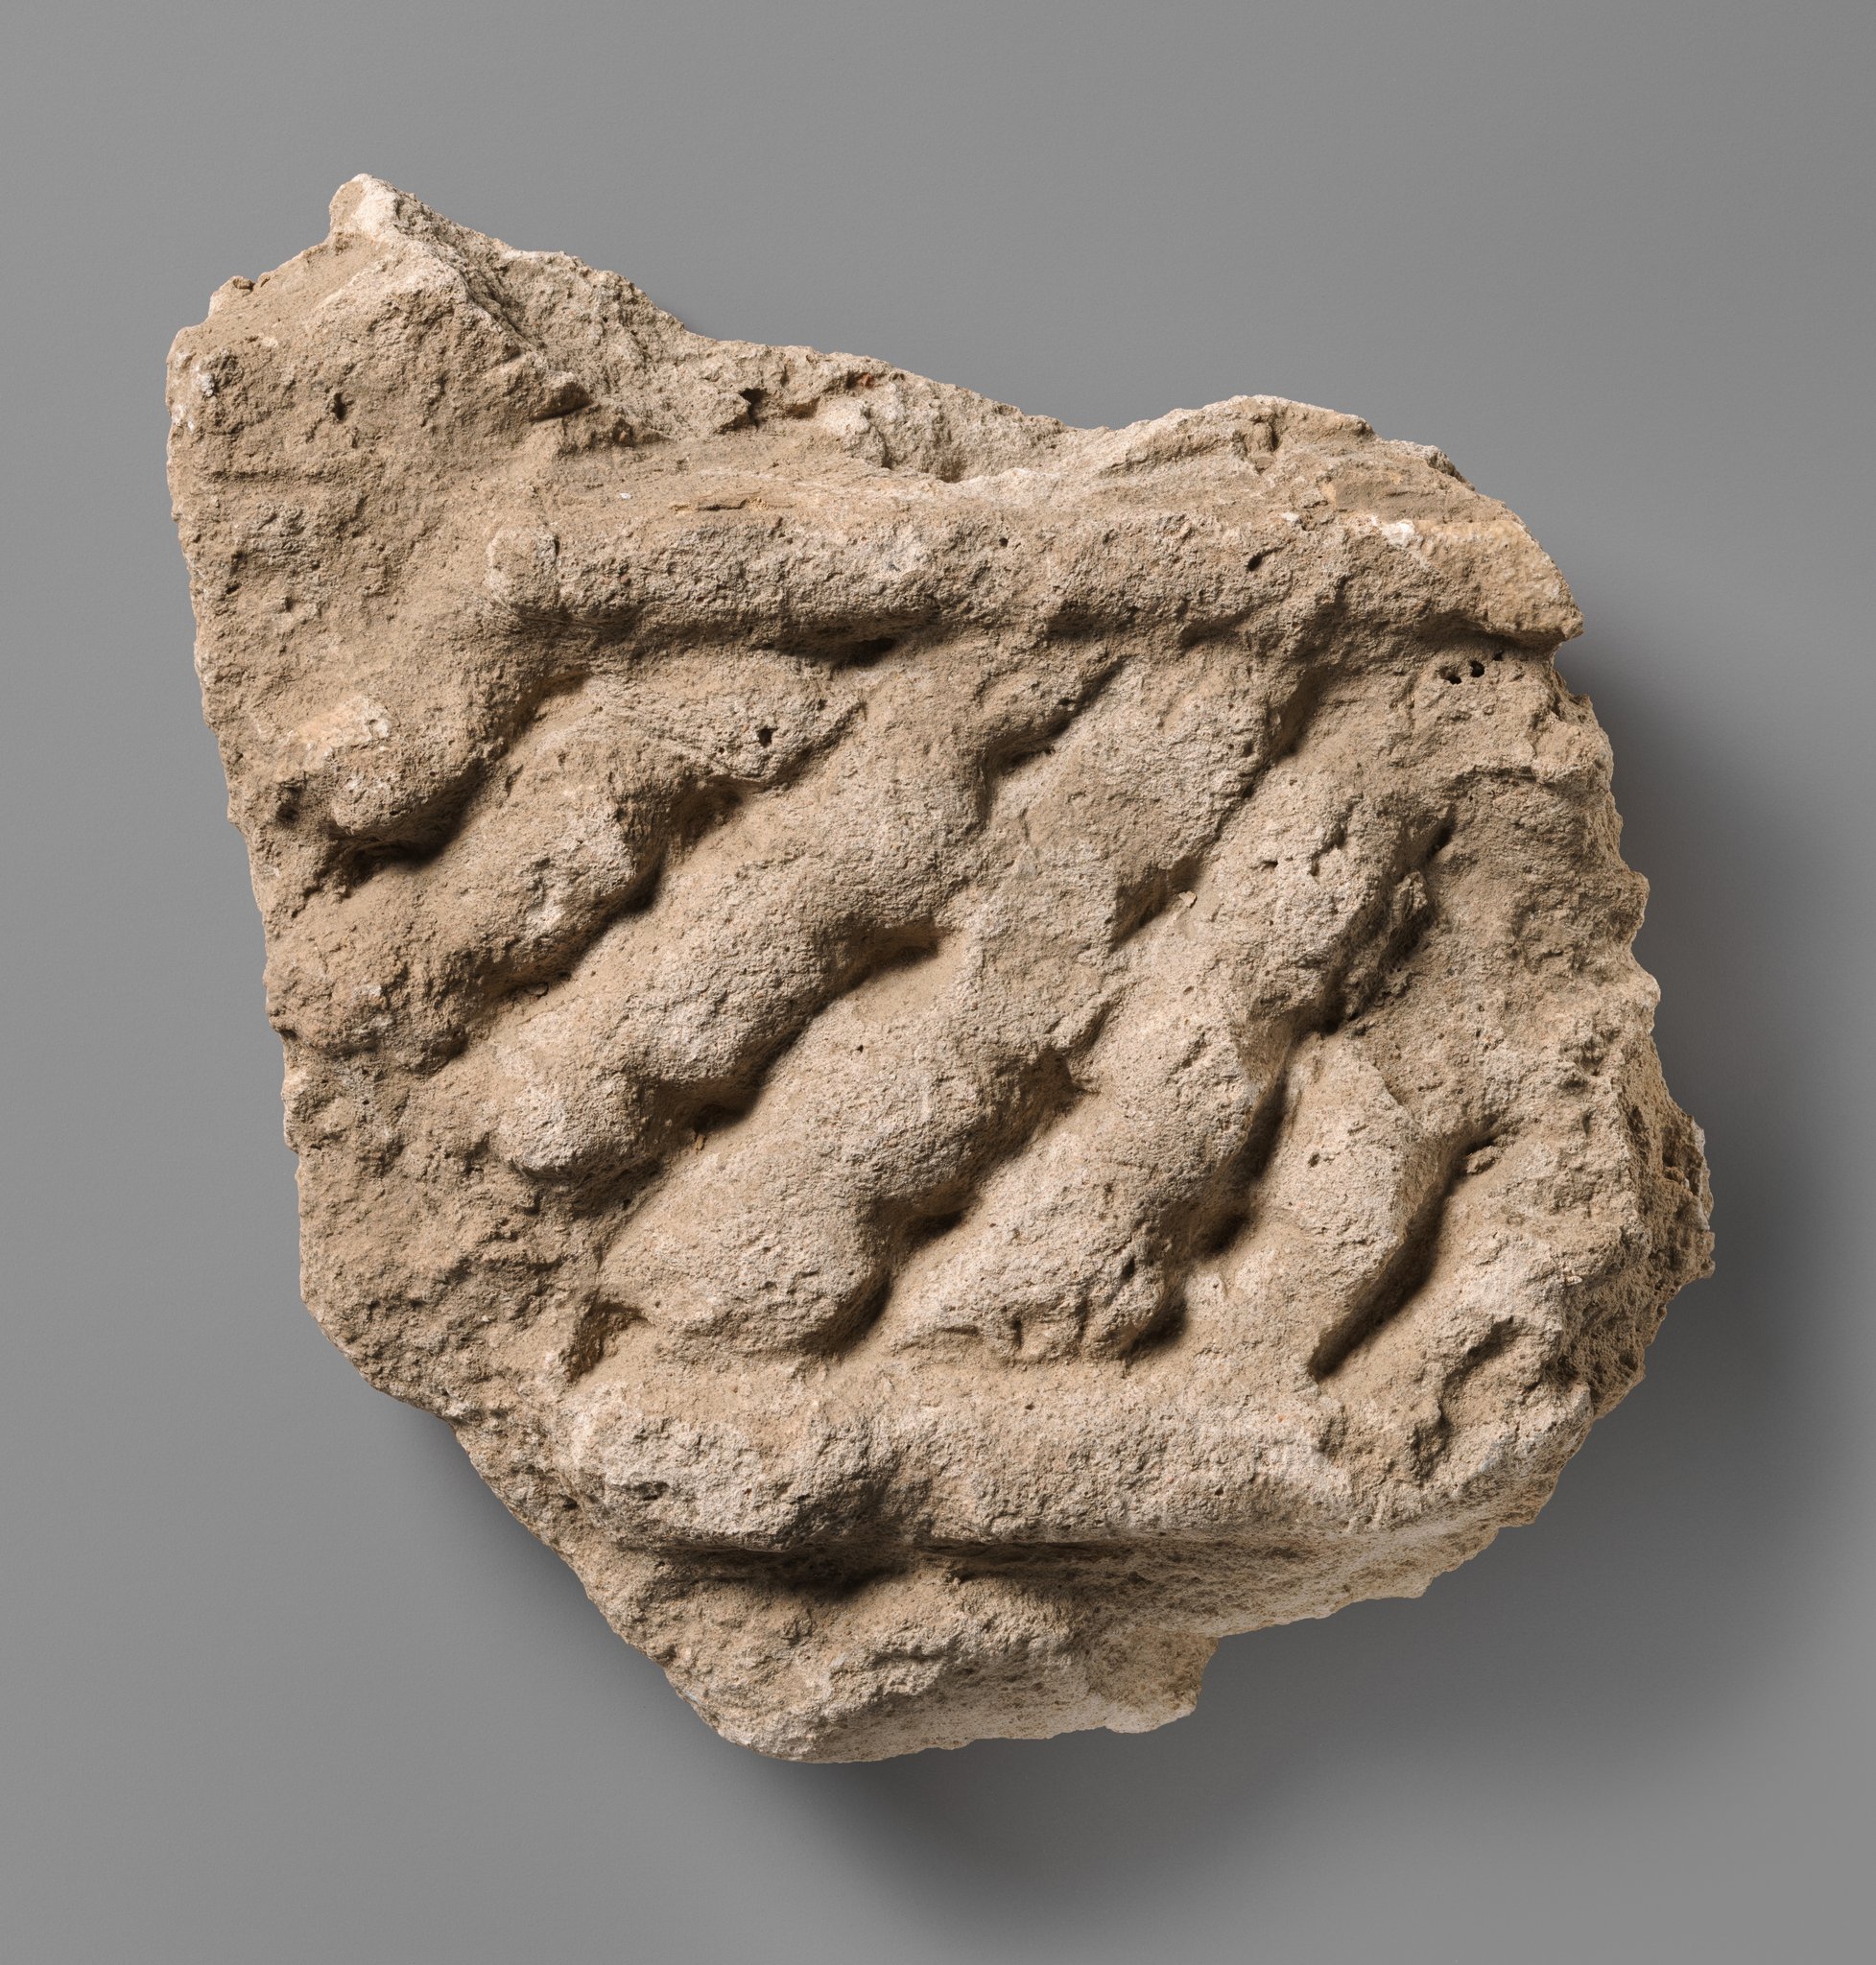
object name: relief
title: Relief fragment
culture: sasanian or islamic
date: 501-800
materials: plaster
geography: mesopotamia